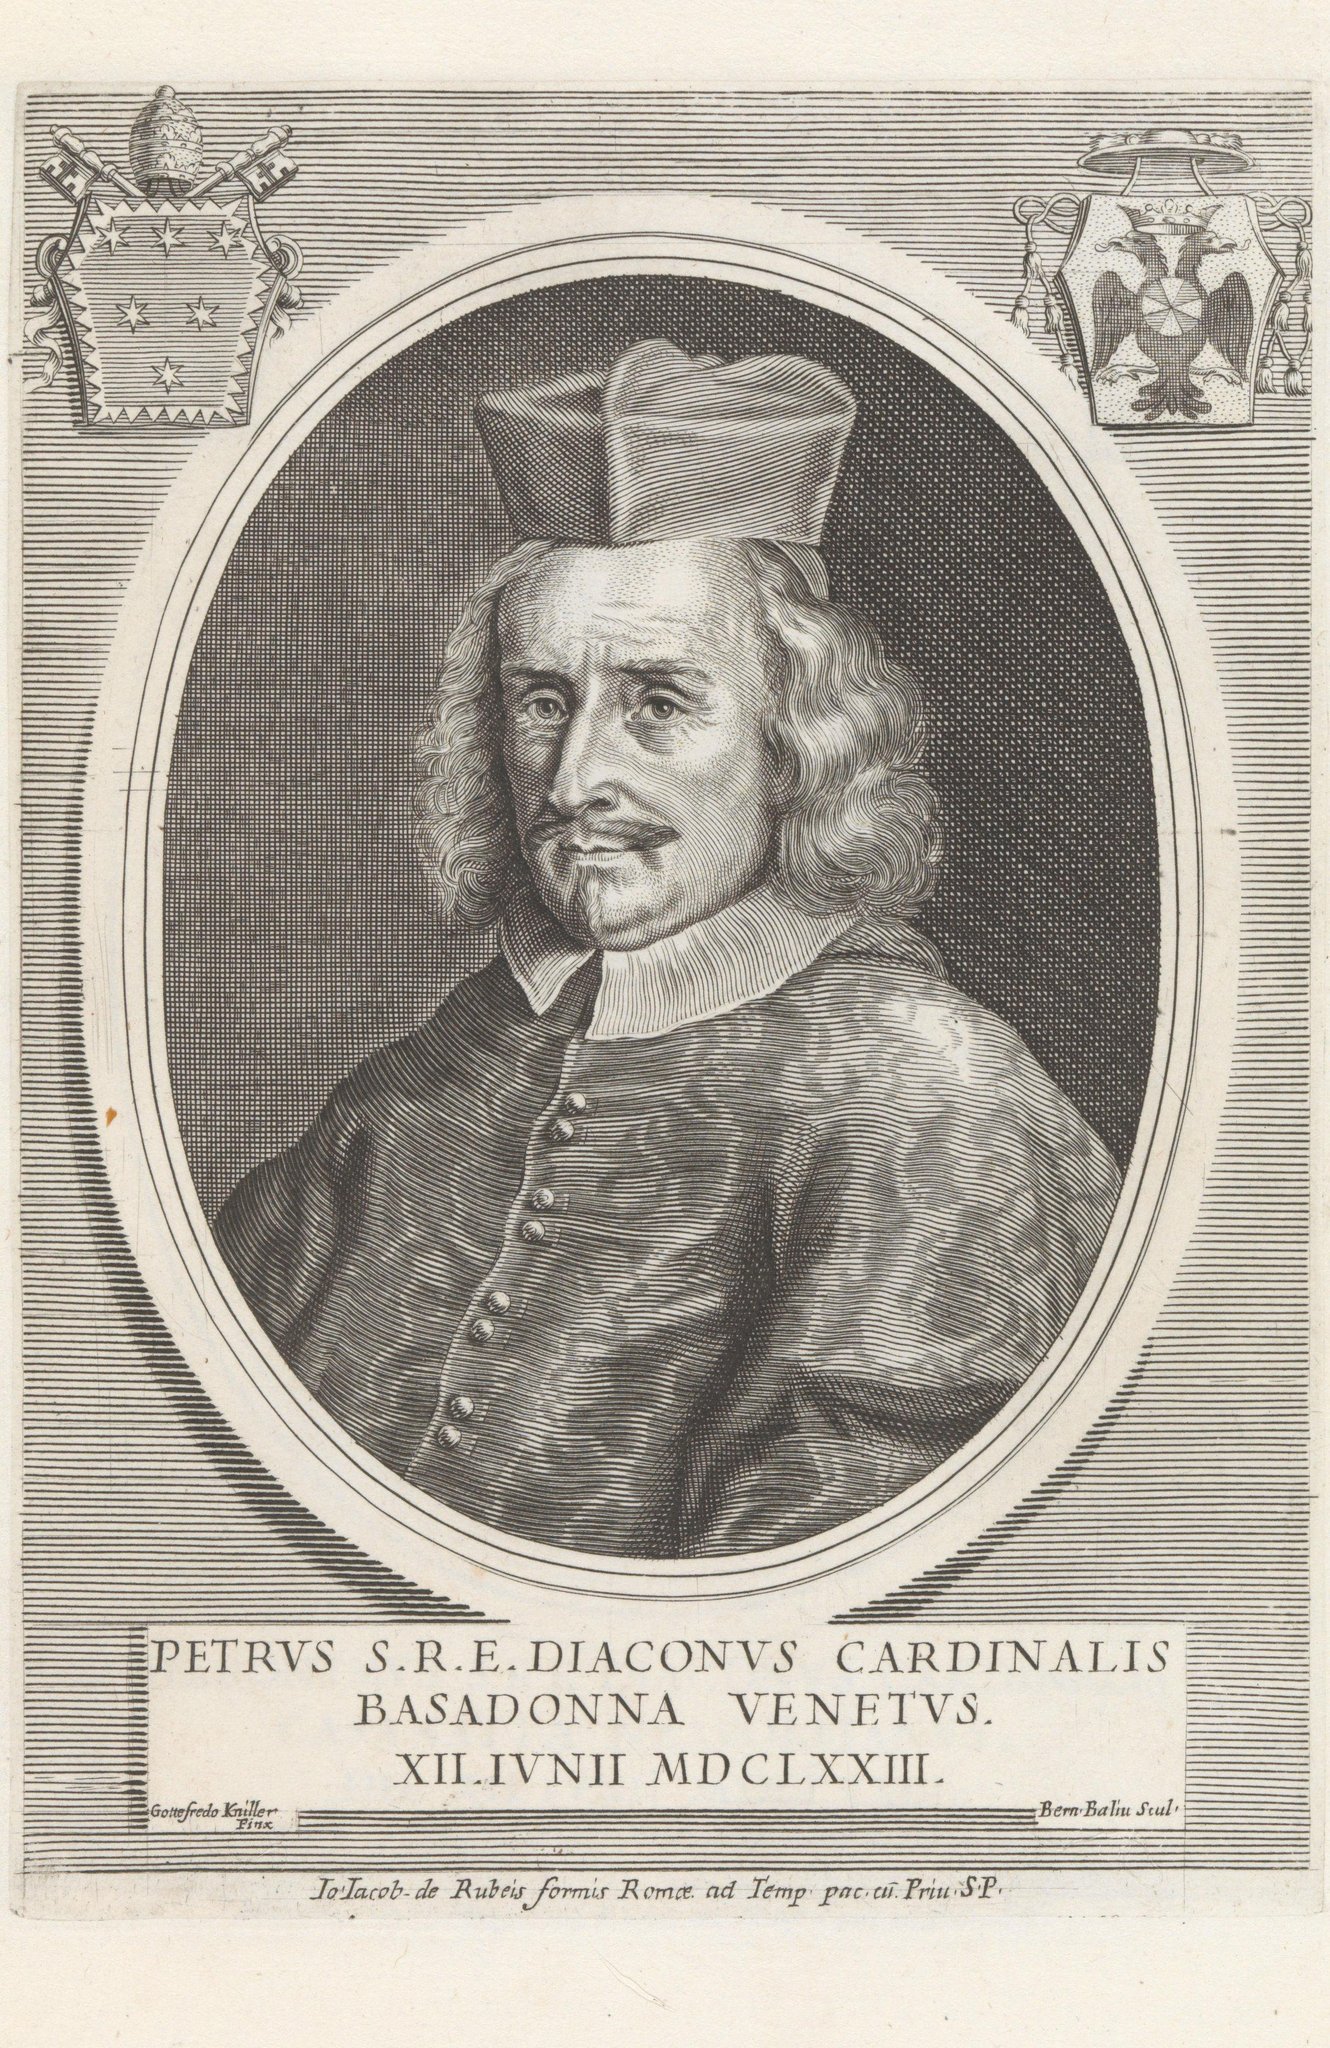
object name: album leaf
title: Effigies Nomina et Cognomina S.D.N. Alexandri Papae VII et RR. DD. SRE. Cardd (...).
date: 1673-1691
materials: paper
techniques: engraving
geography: rome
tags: cardinal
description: Portret van kardinaal Pietro Basadonna. Linksboven het wapen van paus Clemens X en rechtsboven het wapen van de kardinaal. Onderaan een onderschrift in het Latijn. De prent maakt deel uit van een album.